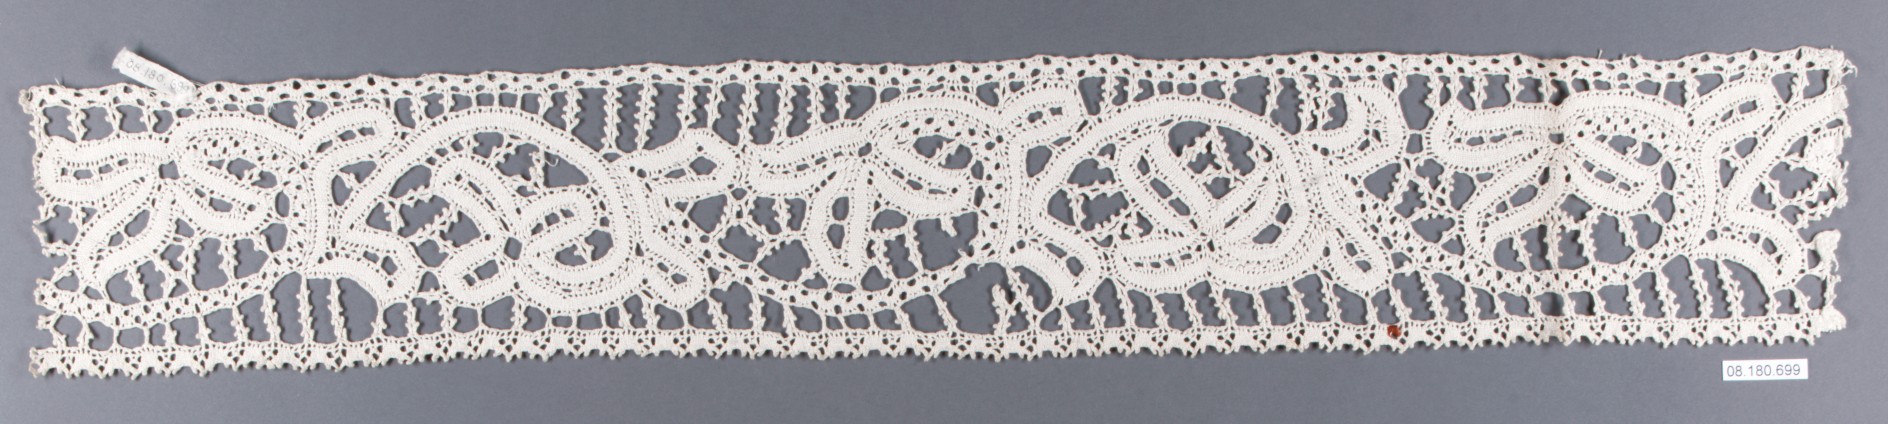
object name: piece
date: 1701-1800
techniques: lace